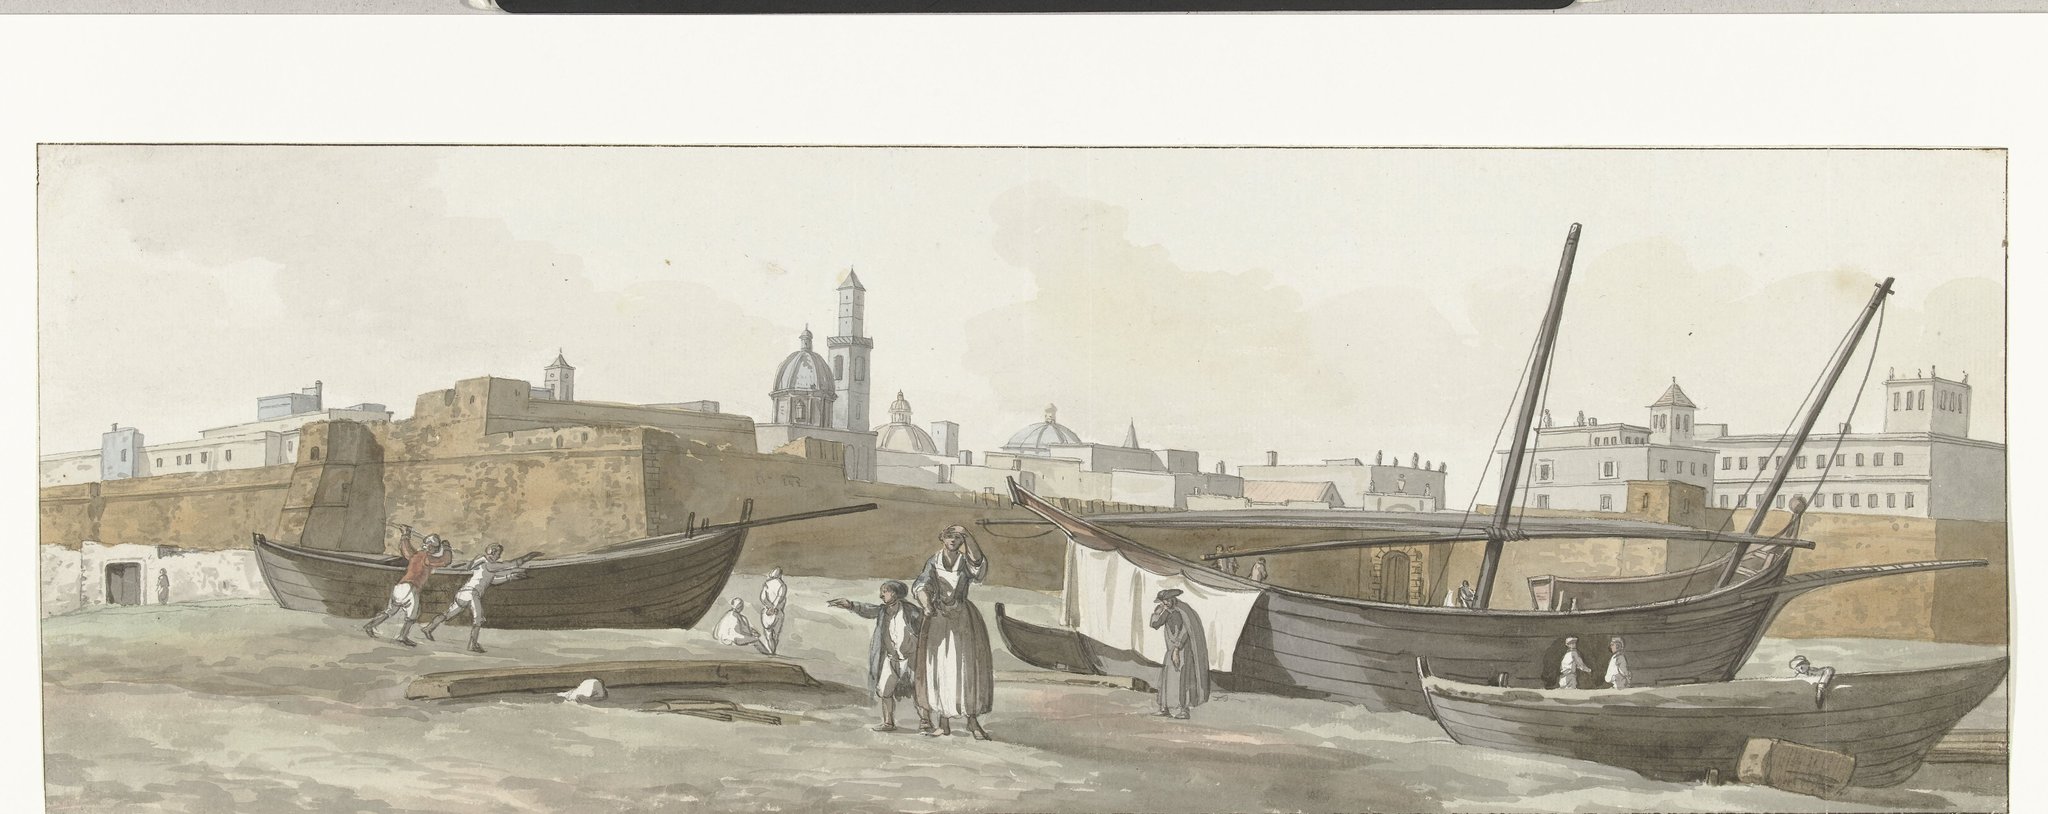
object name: watercolor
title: Voyage en Italie, en Sicile et à Malte - 1778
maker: louis ducros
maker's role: draughtsman, print maker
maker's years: 1748-1810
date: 1778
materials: chalk, paper, watercolor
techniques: brush, pen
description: Tekening uit het album 'Voyage en Italie, en Sicile et à Malte', 1778.